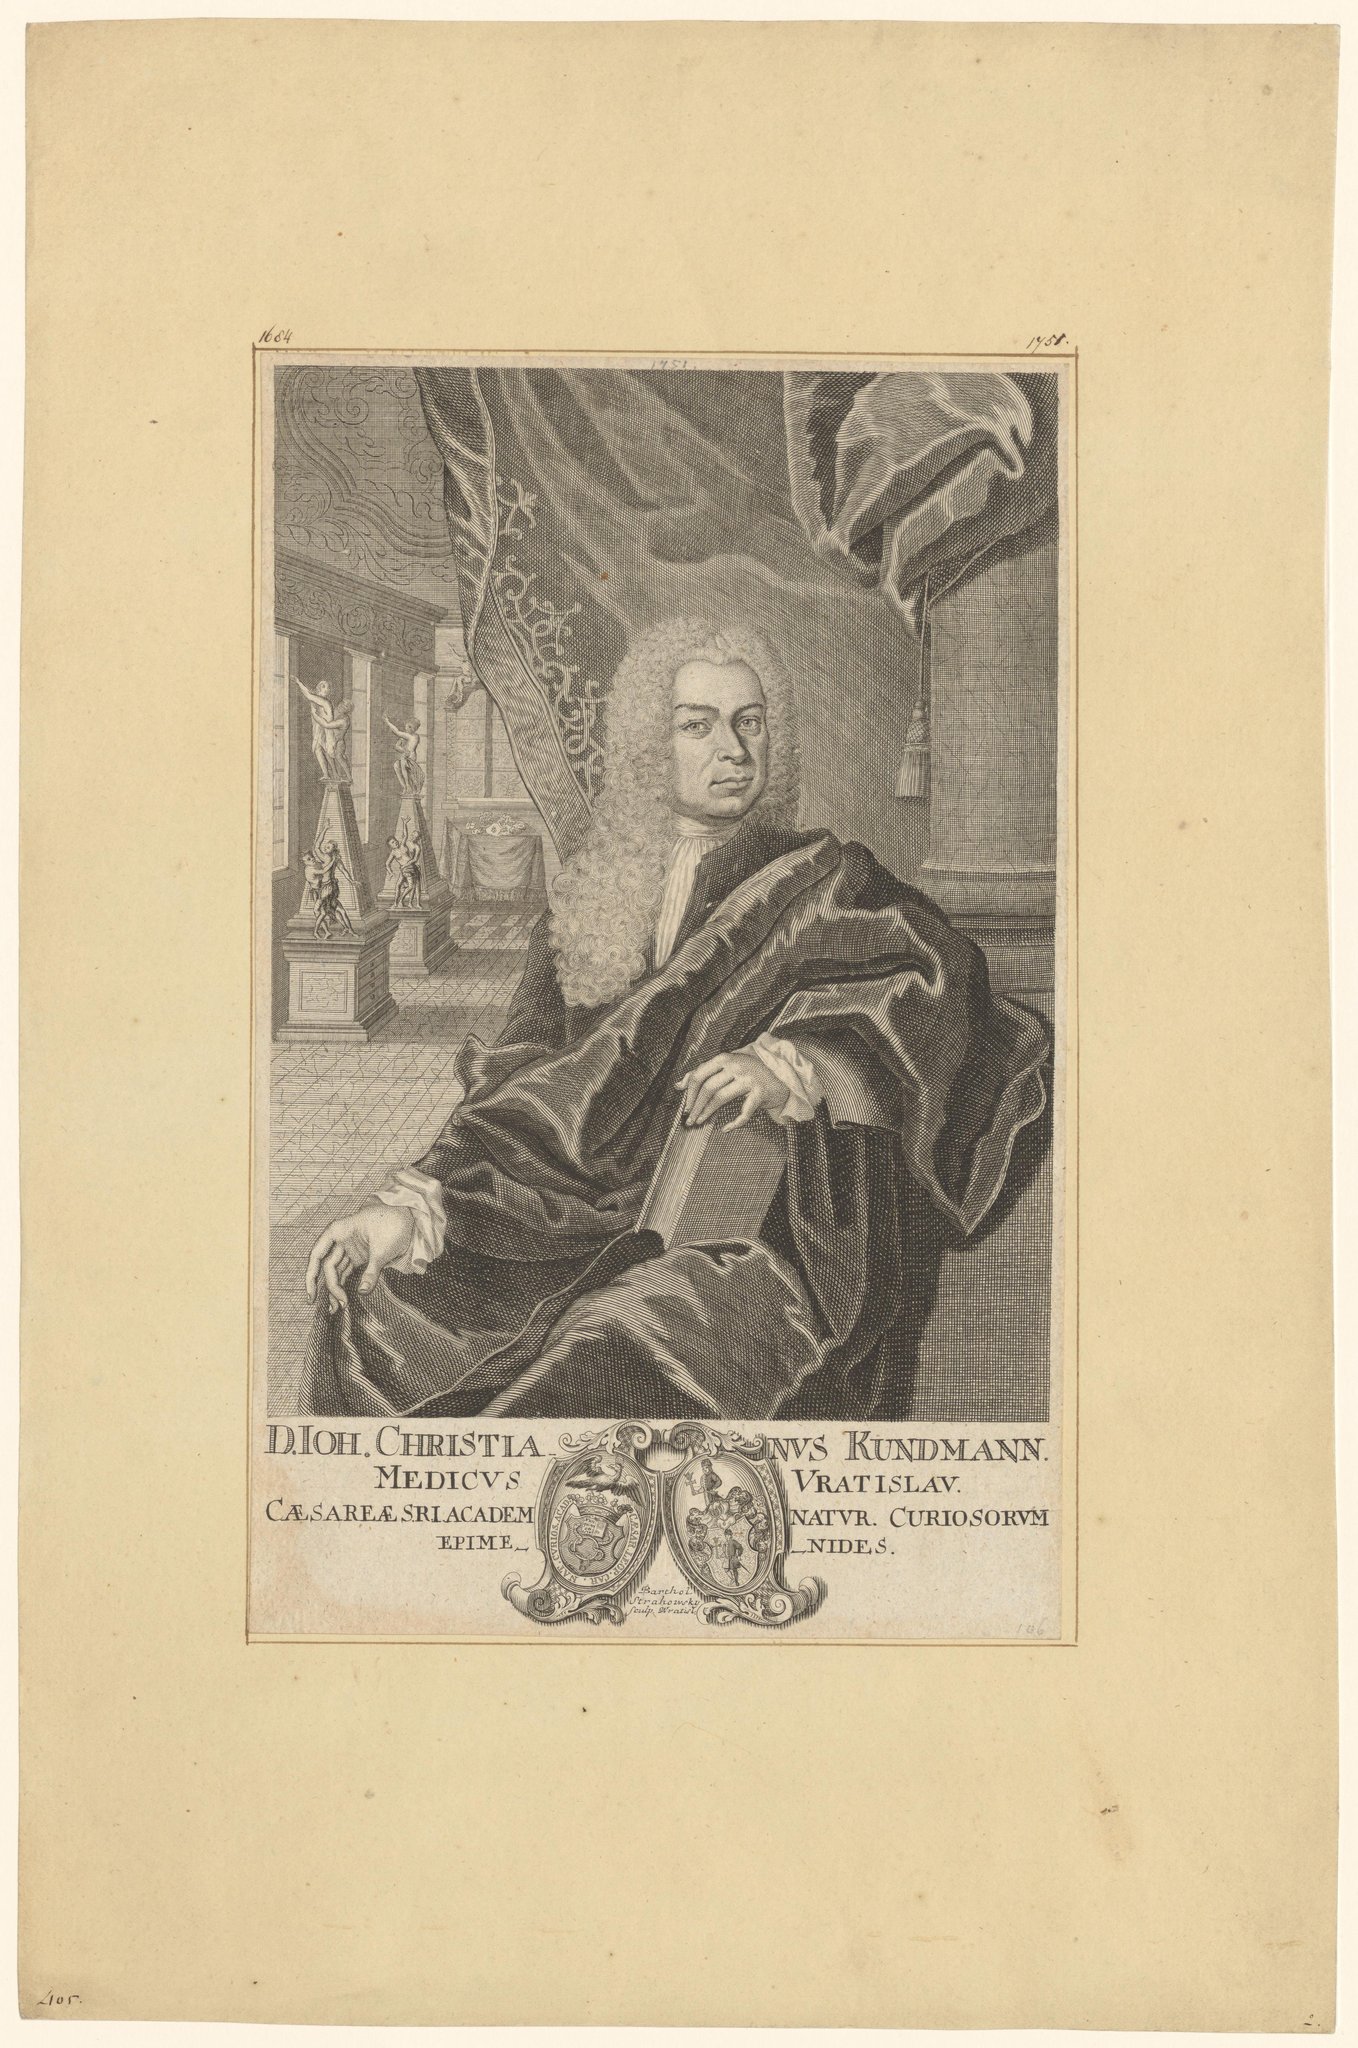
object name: print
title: Portret van Johann Christian Kundmann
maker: bartholomäus strahowsky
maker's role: print maker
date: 1737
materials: paper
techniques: engraving, etching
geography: breslau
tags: historical persons, book, cabinet of curiosities, 'kunst- und wunderkammer', armorial bearing, heraldry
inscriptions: number: ‘405’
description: De prent is gemonteerd op een opzetvel voorzien van een kader met pen in bruin. Prent gebruikt voor de publicatie: Kundmann, Johann Christian. Rariora naturae et artis, item in re medica, oder Seltenheiten der Natur und Kunst des kundmannischen Naturalien-Cabinets. Breslau en Leipzig: Michael Hubert, 1737.